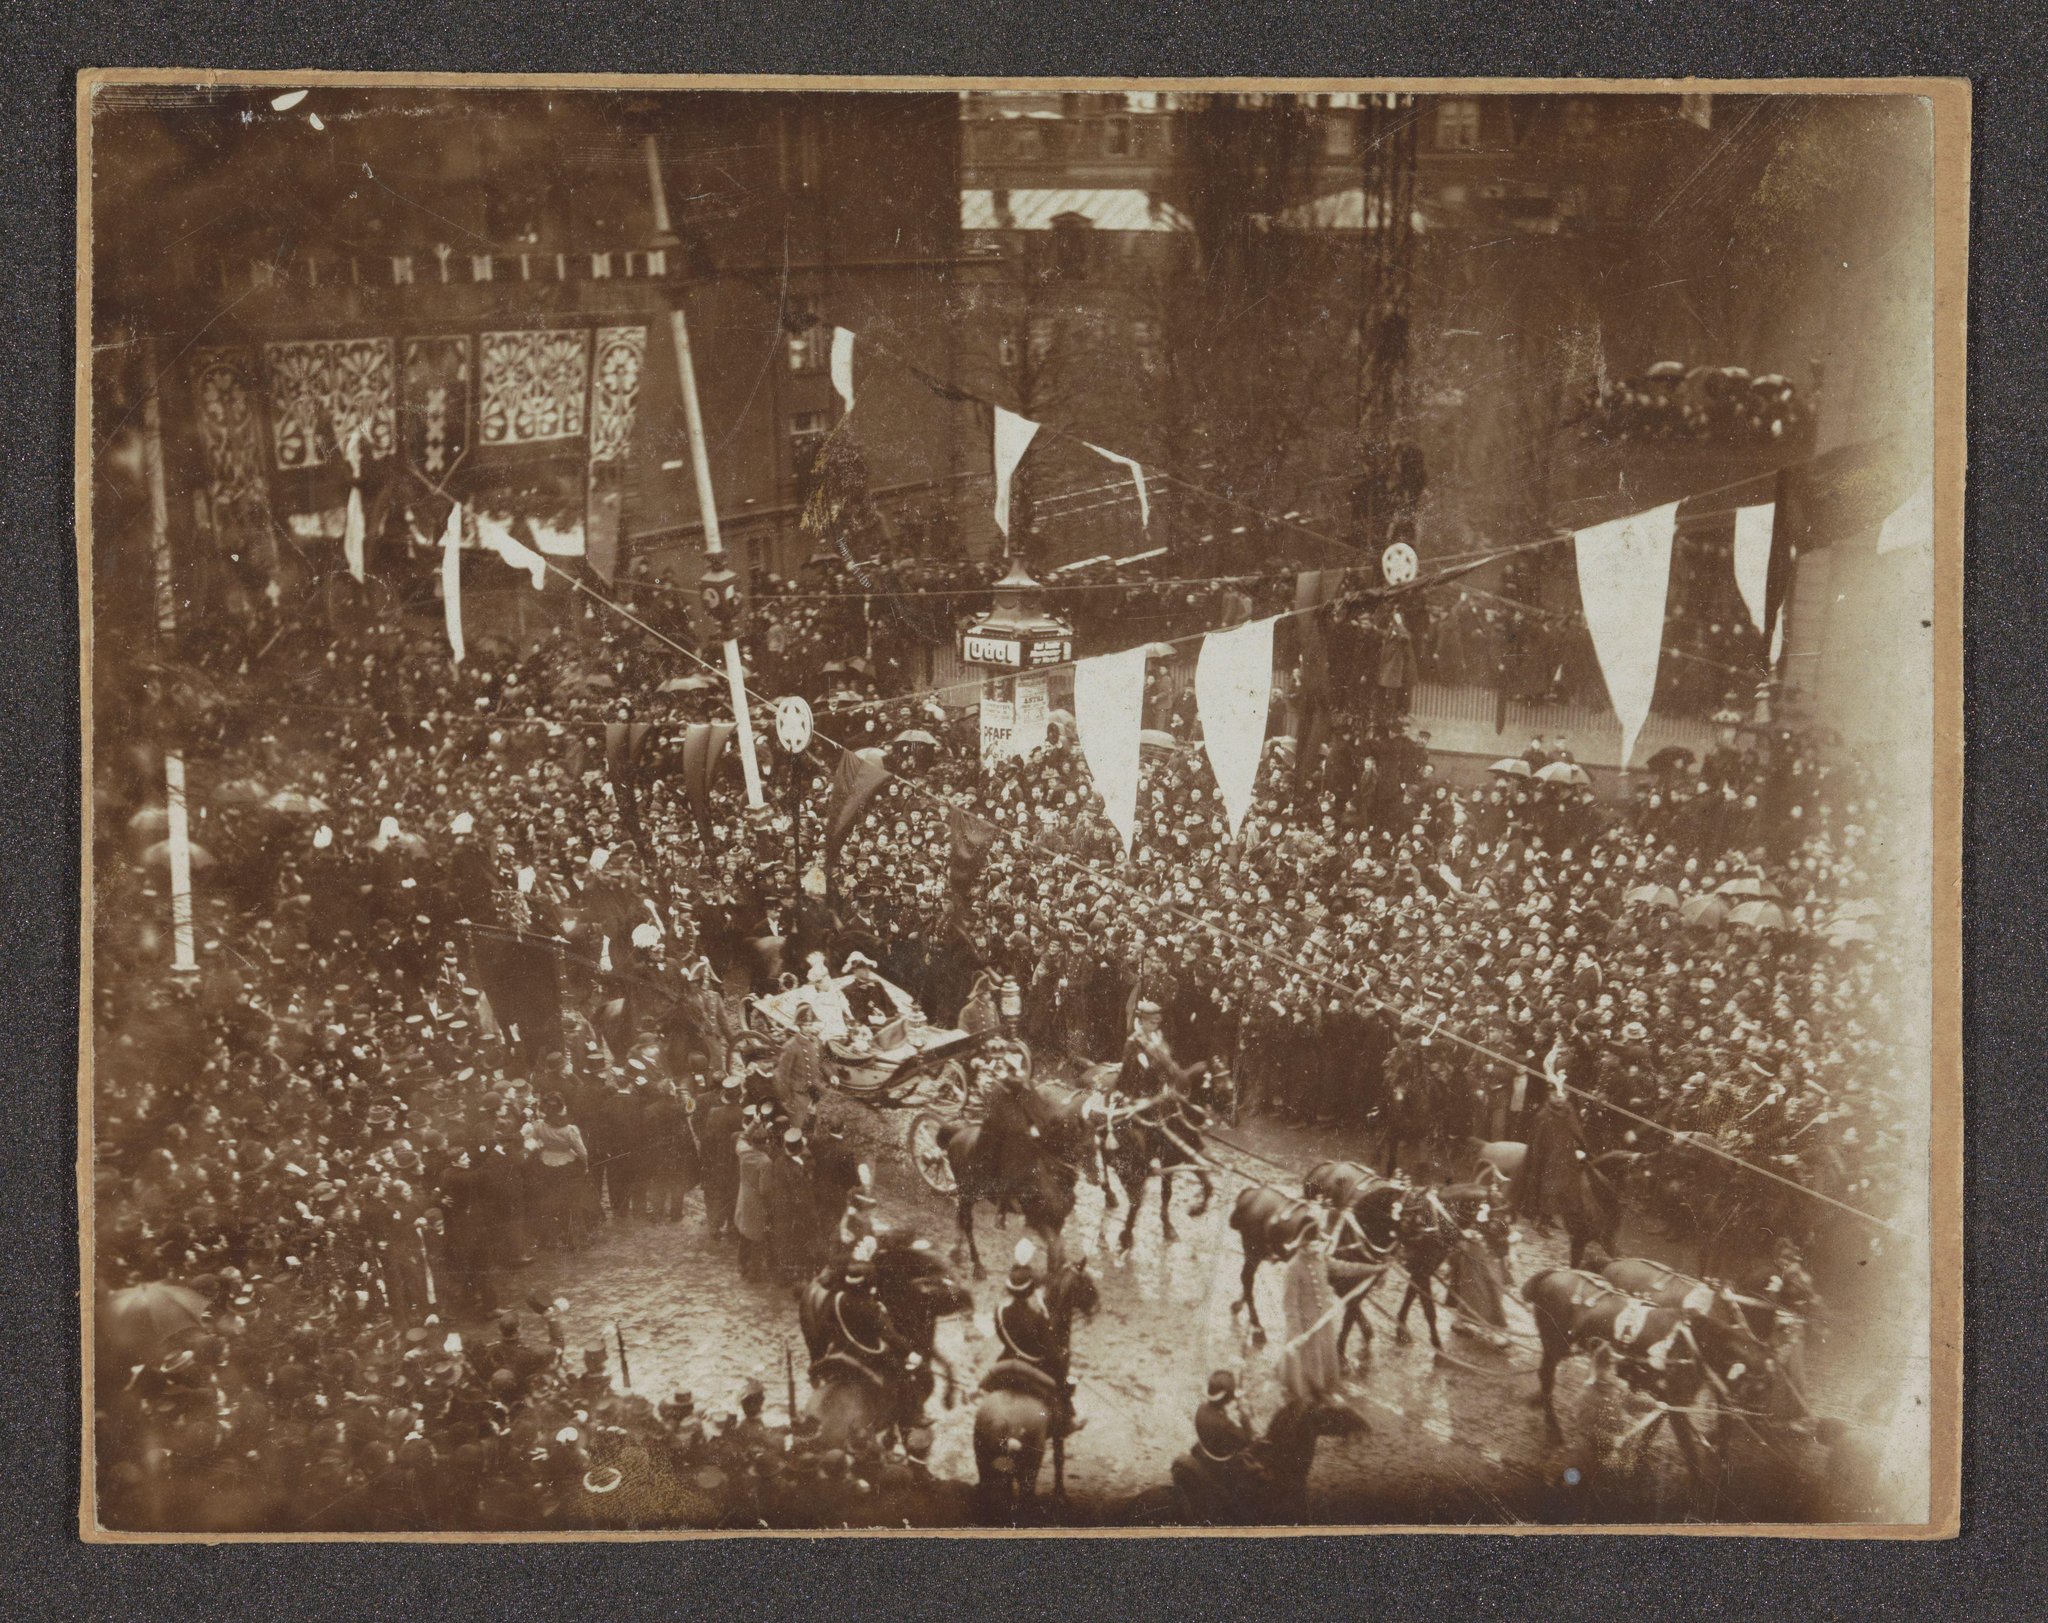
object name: photograph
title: Prins Hendrik en koningin Wilhelmina in een rijtuig in Amsterdam omringd door veel publiek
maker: Anonymous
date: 1900-1930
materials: cardboard, photographic support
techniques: gelatin silver print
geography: netherlands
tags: print maker, wilhelmina of the netherlands, the hague, hendrik (prins der nederlanden (1876-1934)), amsterdam